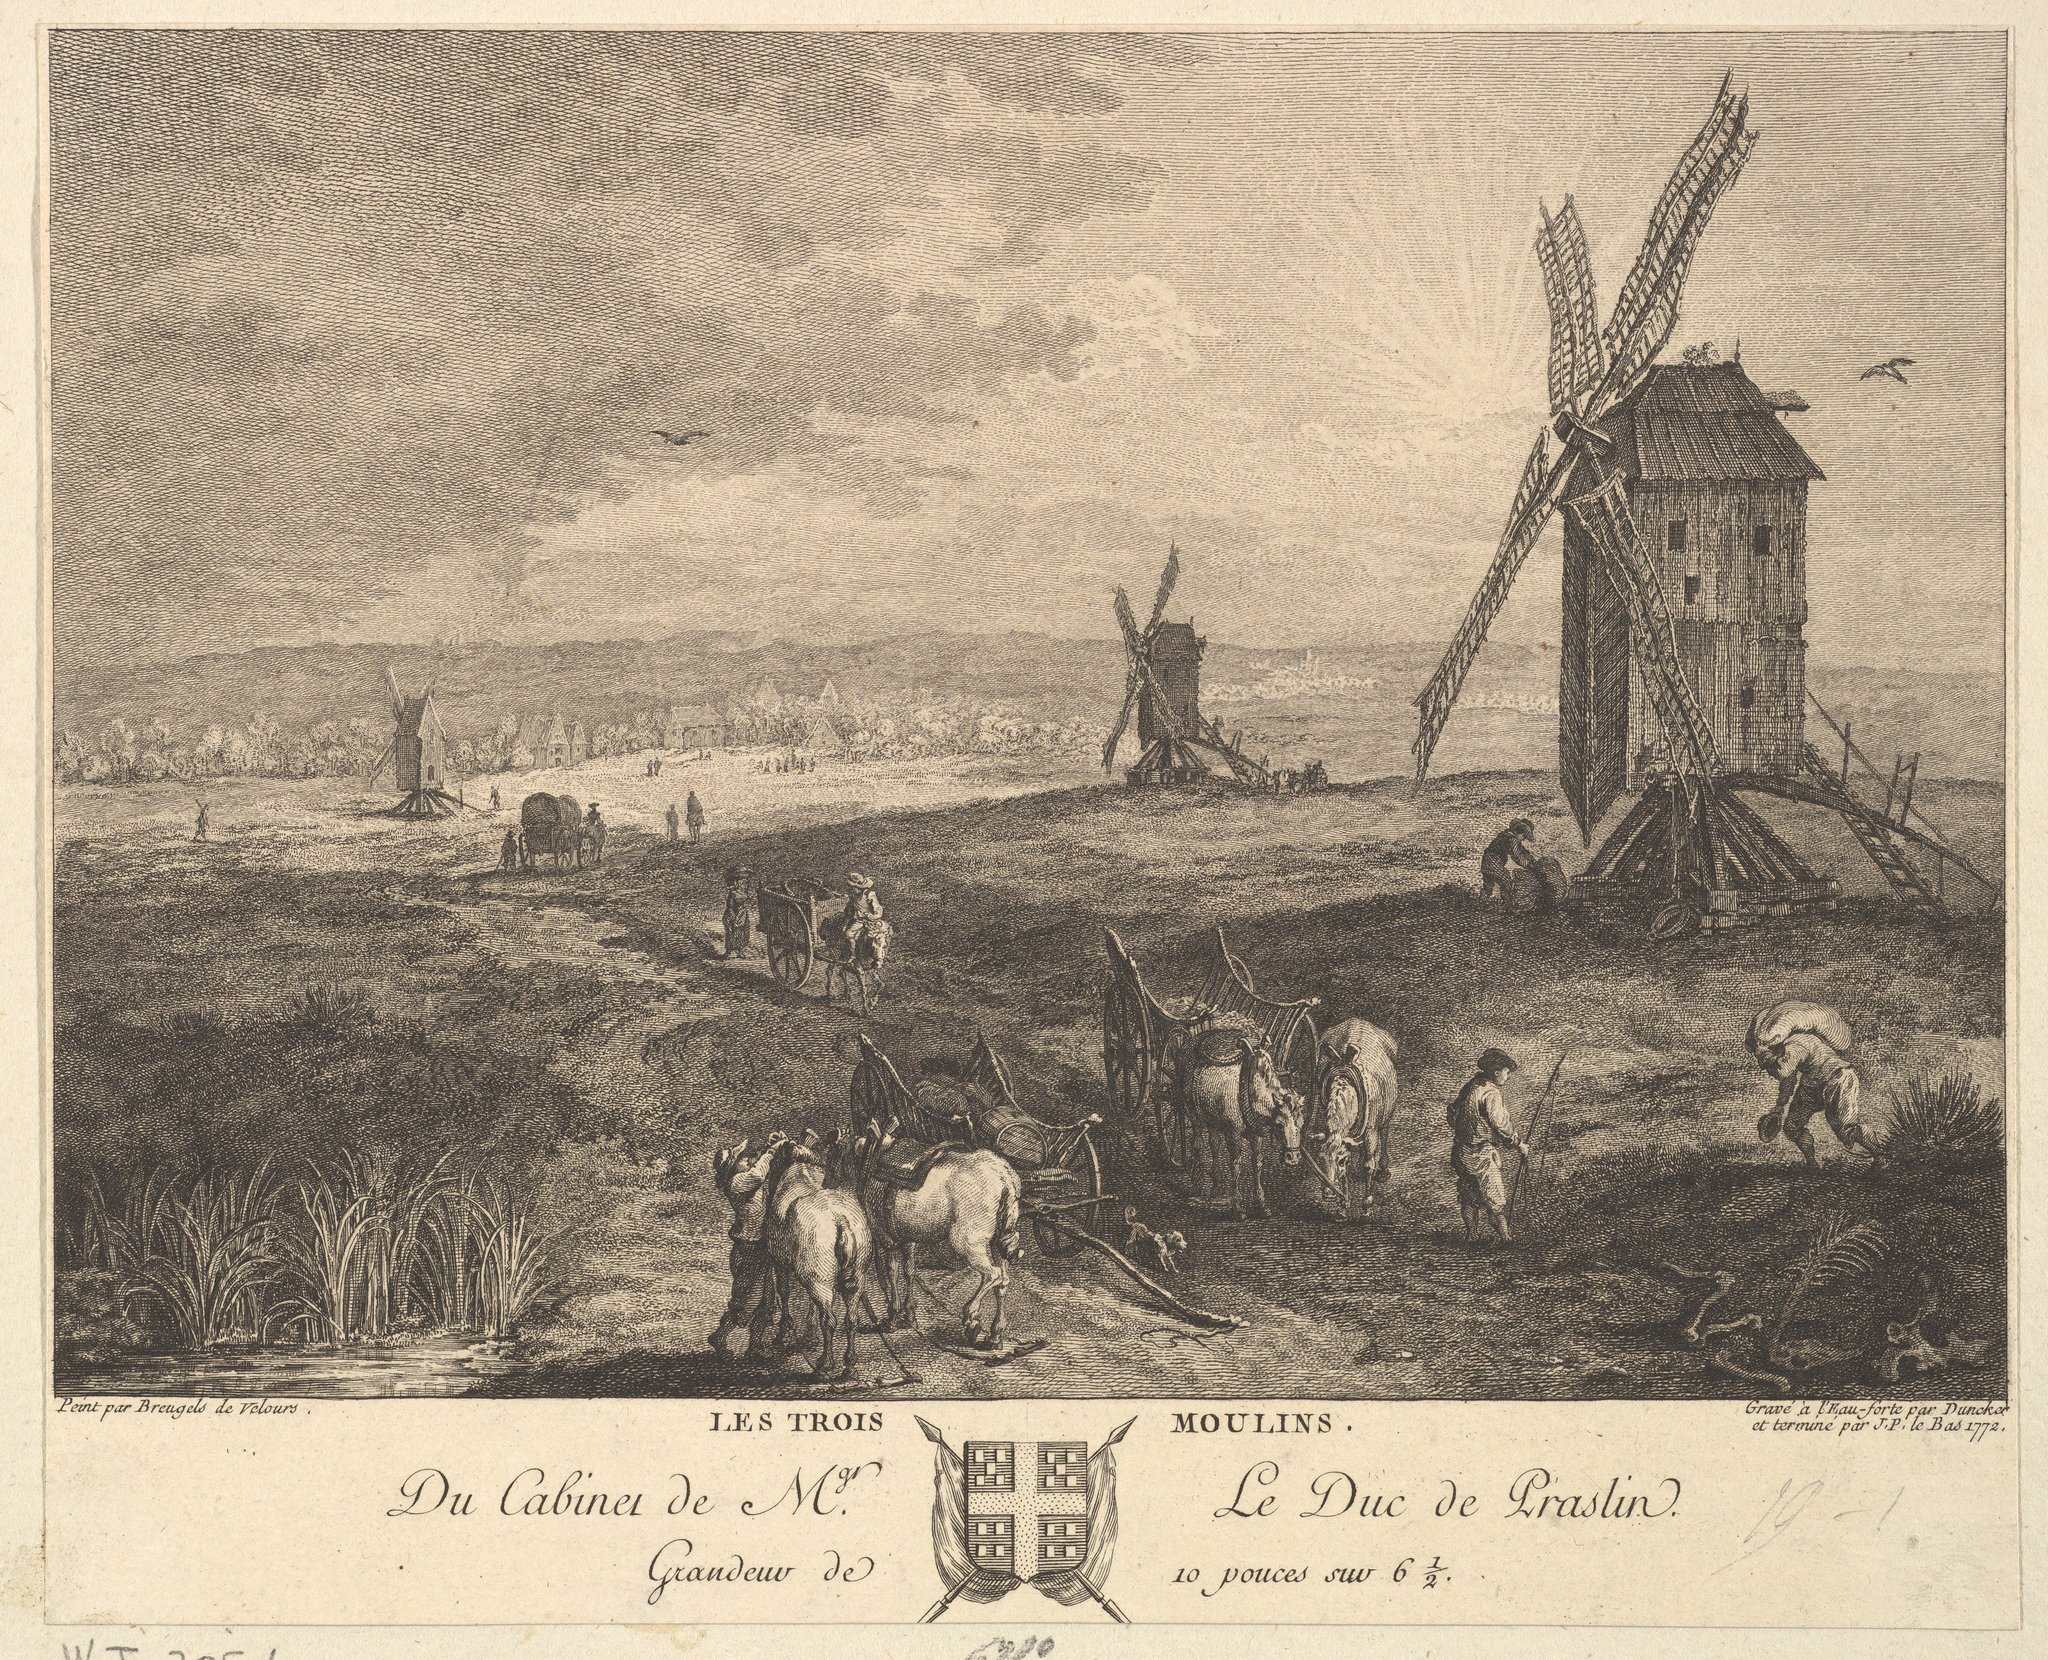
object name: print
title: The Three Windmills (Les Trois Moulins) after a painting in the collection of the Duc de Praslin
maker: balthasar anton dunker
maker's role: artist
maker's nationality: swiss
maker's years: 1746-1807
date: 1772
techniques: engraving, etching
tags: windmills,men,horses,working